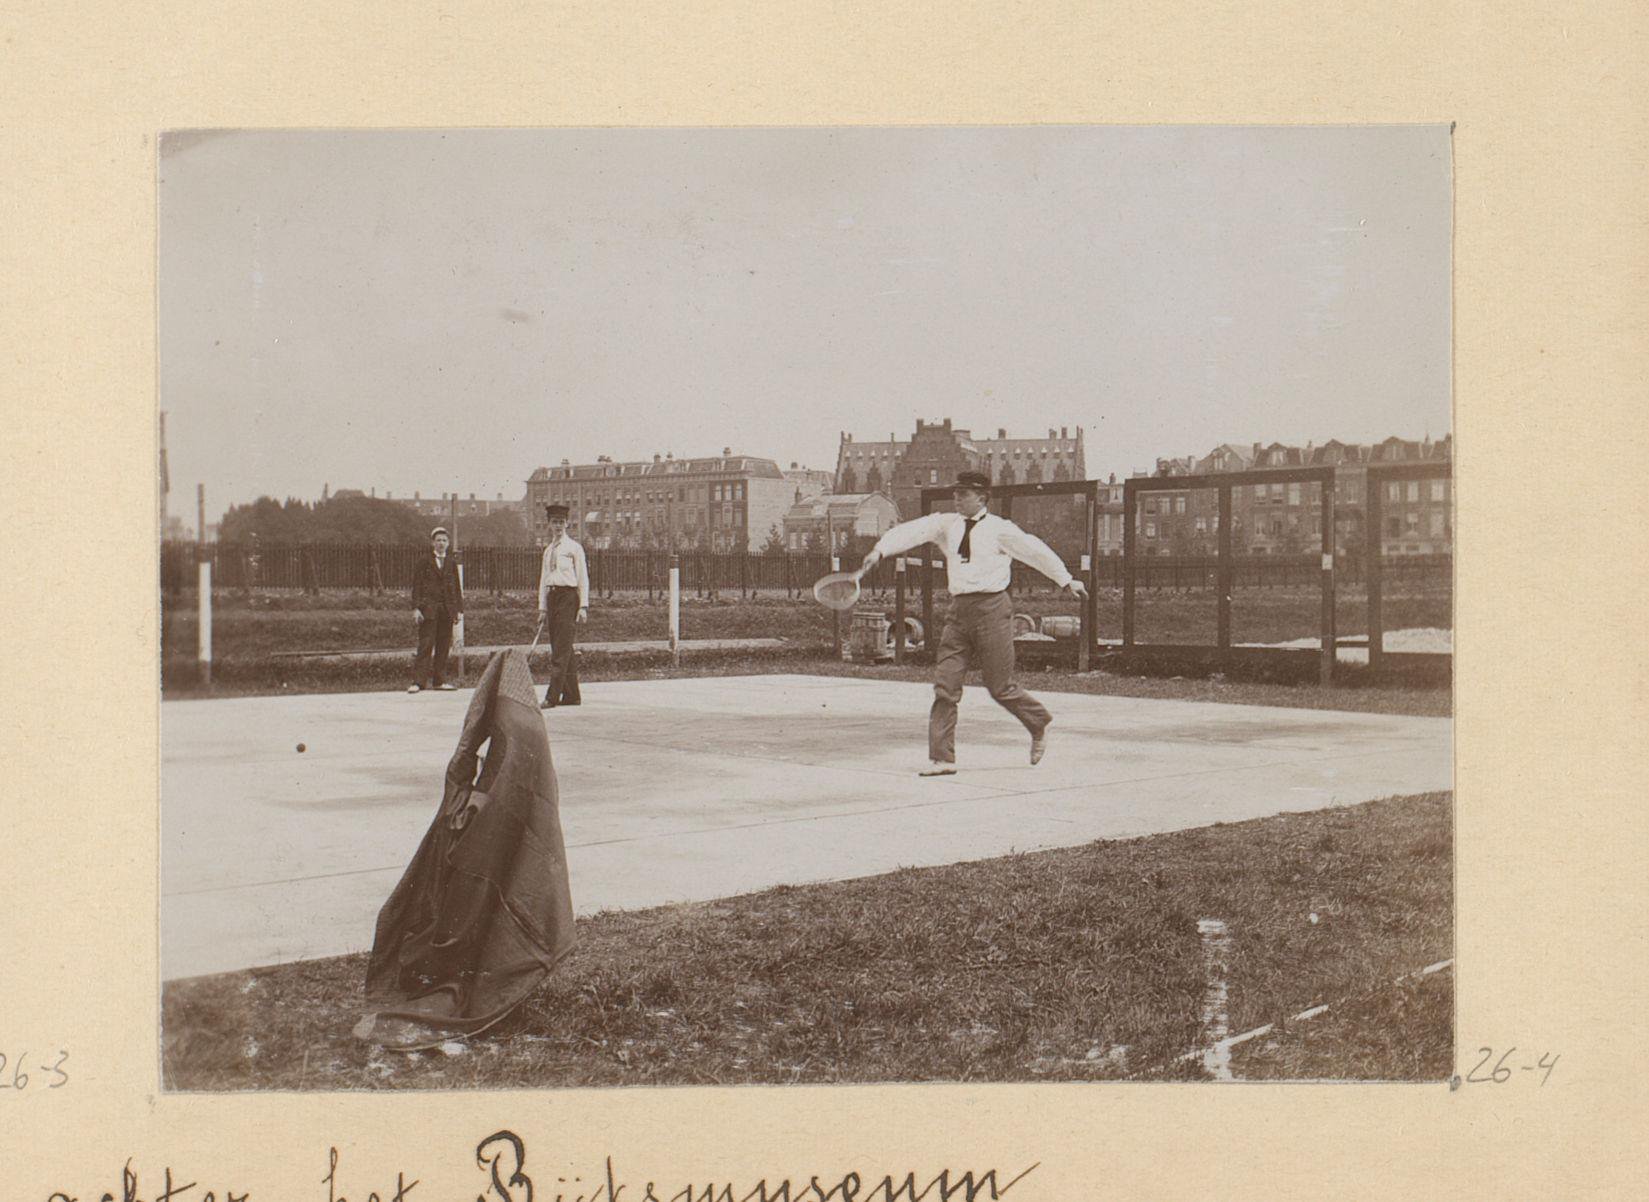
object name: photograph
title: Twee mannen spelen tennis op de baan achter het Rijksmuseum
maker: hendrik herman van den berg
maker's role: amateurfotograaf, jurist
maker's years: 1875-1944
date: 1890-1894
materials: paper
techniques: collodion silver print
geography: amsterdam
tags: tennis, lawn-tennis, historical persons, amsterdam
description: Foto 4 op albumblad 26 uit album "Amsterdam 1890-1894".